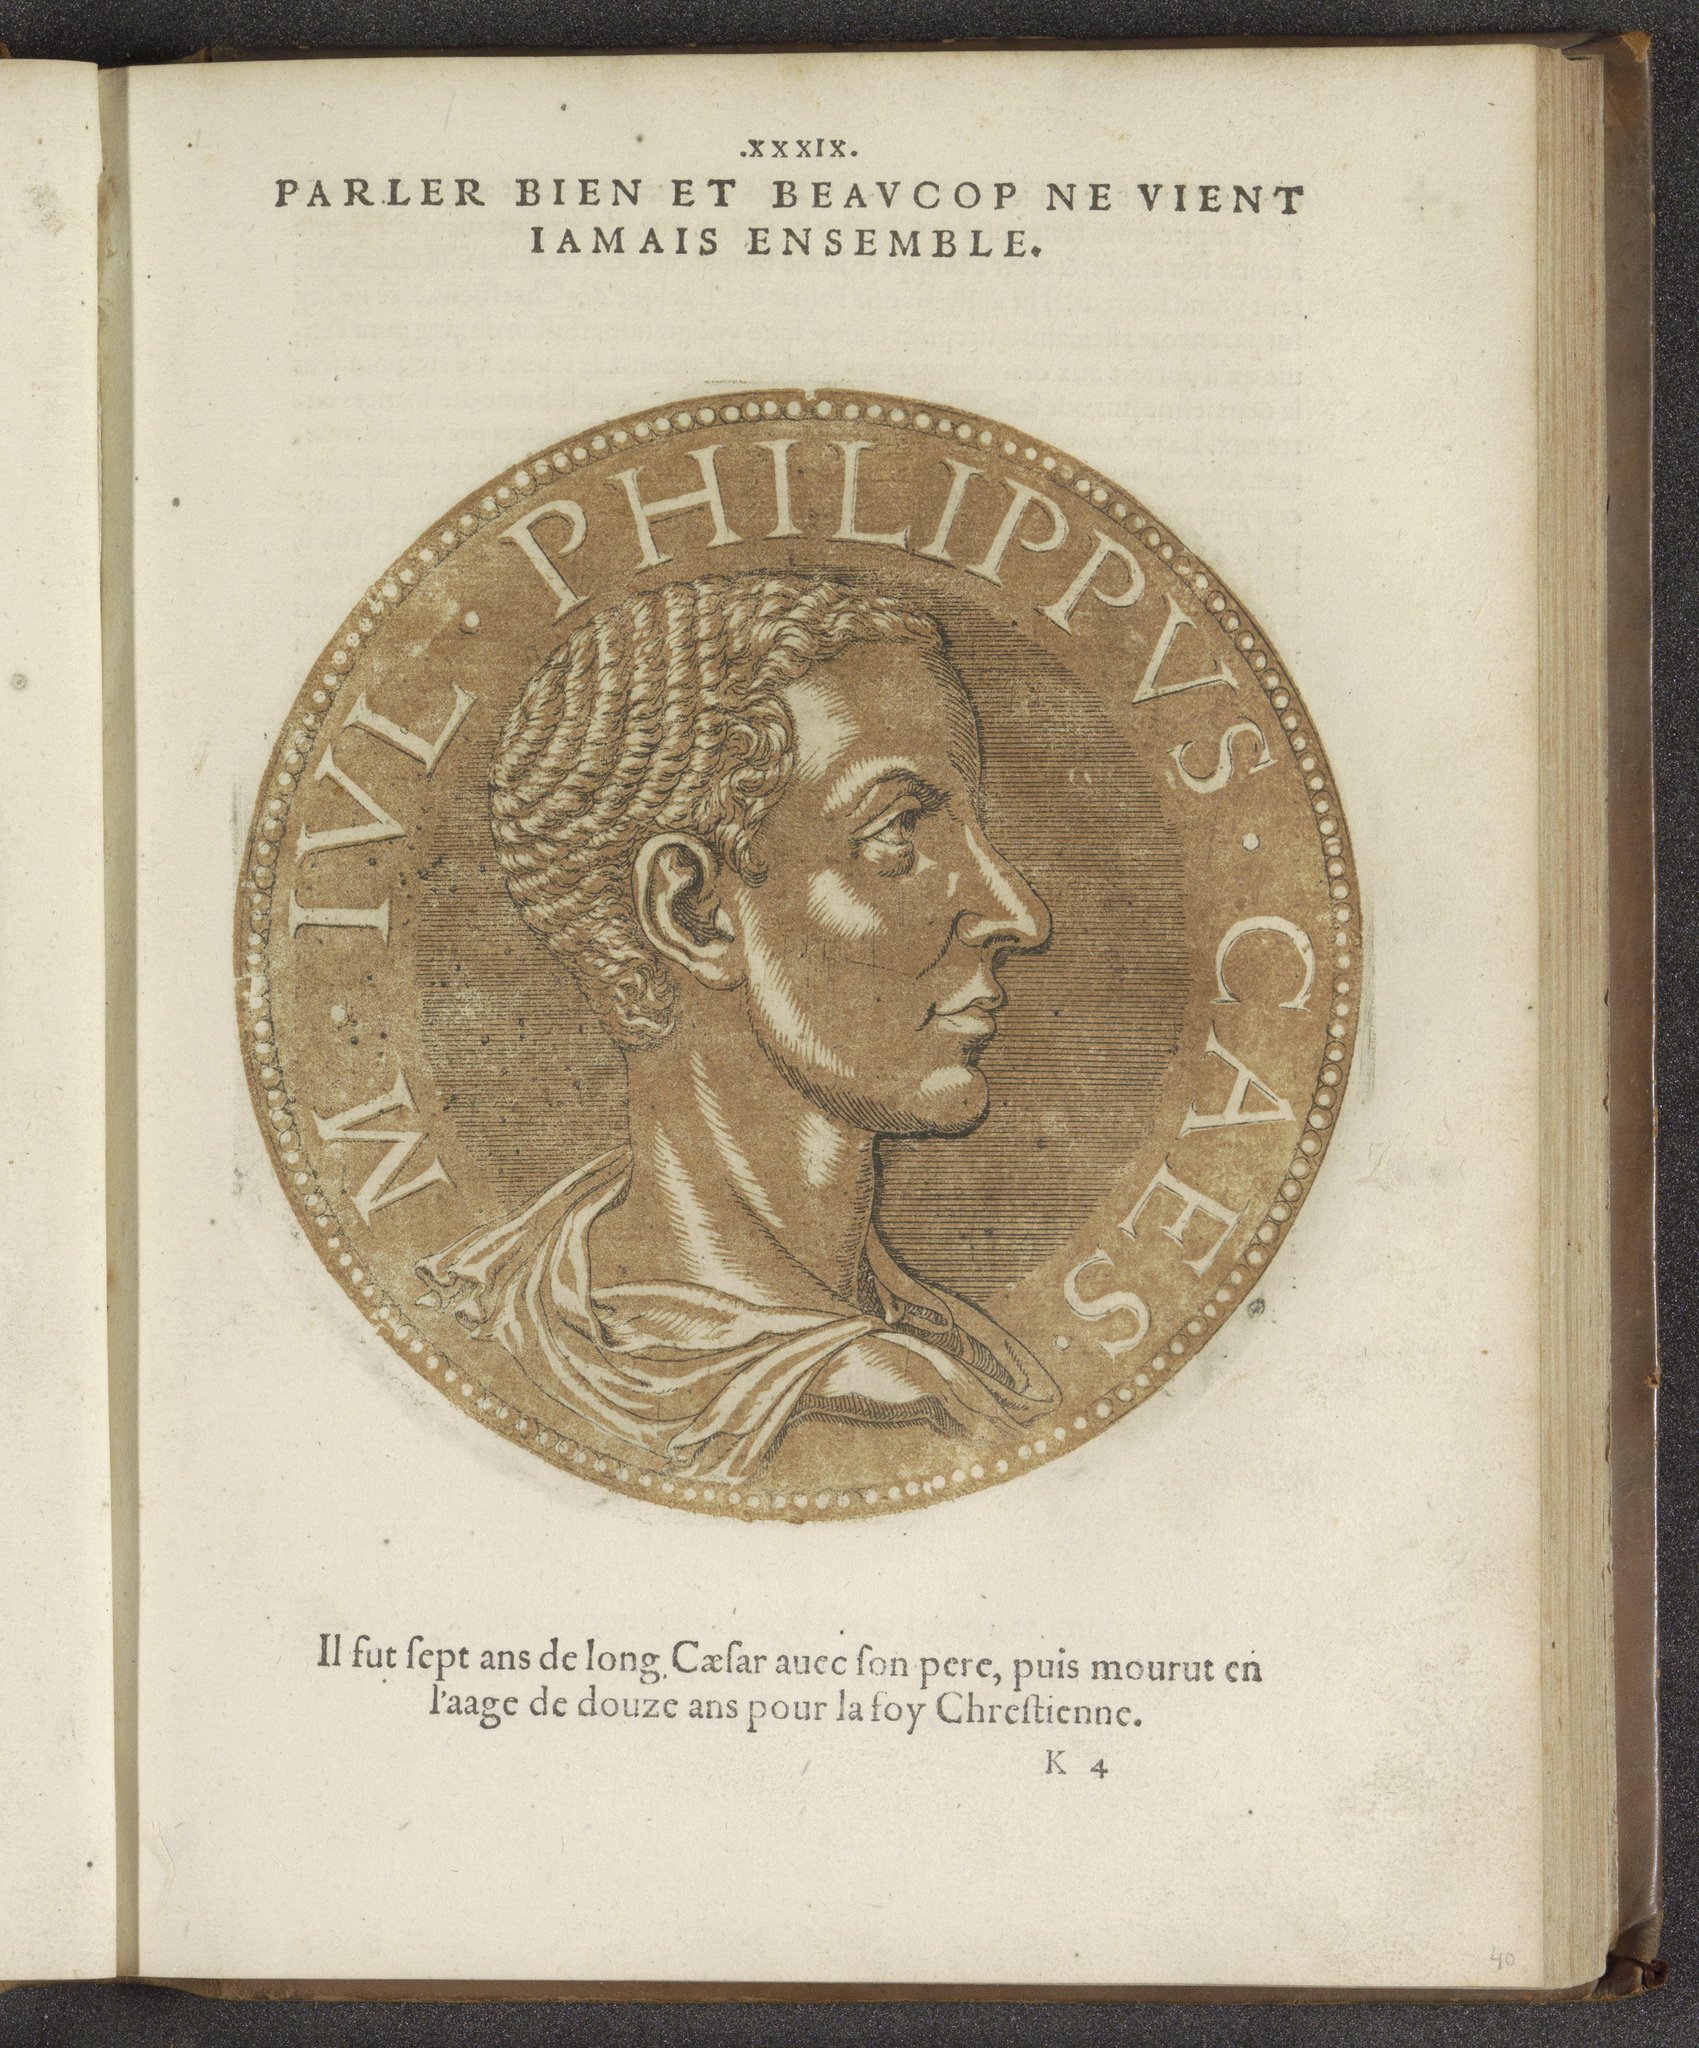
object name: page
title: Les images presque de tous les empereurs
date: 1557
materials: paper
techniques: woodcut, etching, letterpress printing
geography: antwerp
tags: emperor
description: Portret van keizer Philippus II (zoon en medekeizer van Philippus I Arabs), op een munt met randschrift. De prent maakt deel uit van een boek over de keizers vanaf Julius Caesar tot en met Karel V en zijn broer Ferdinand.